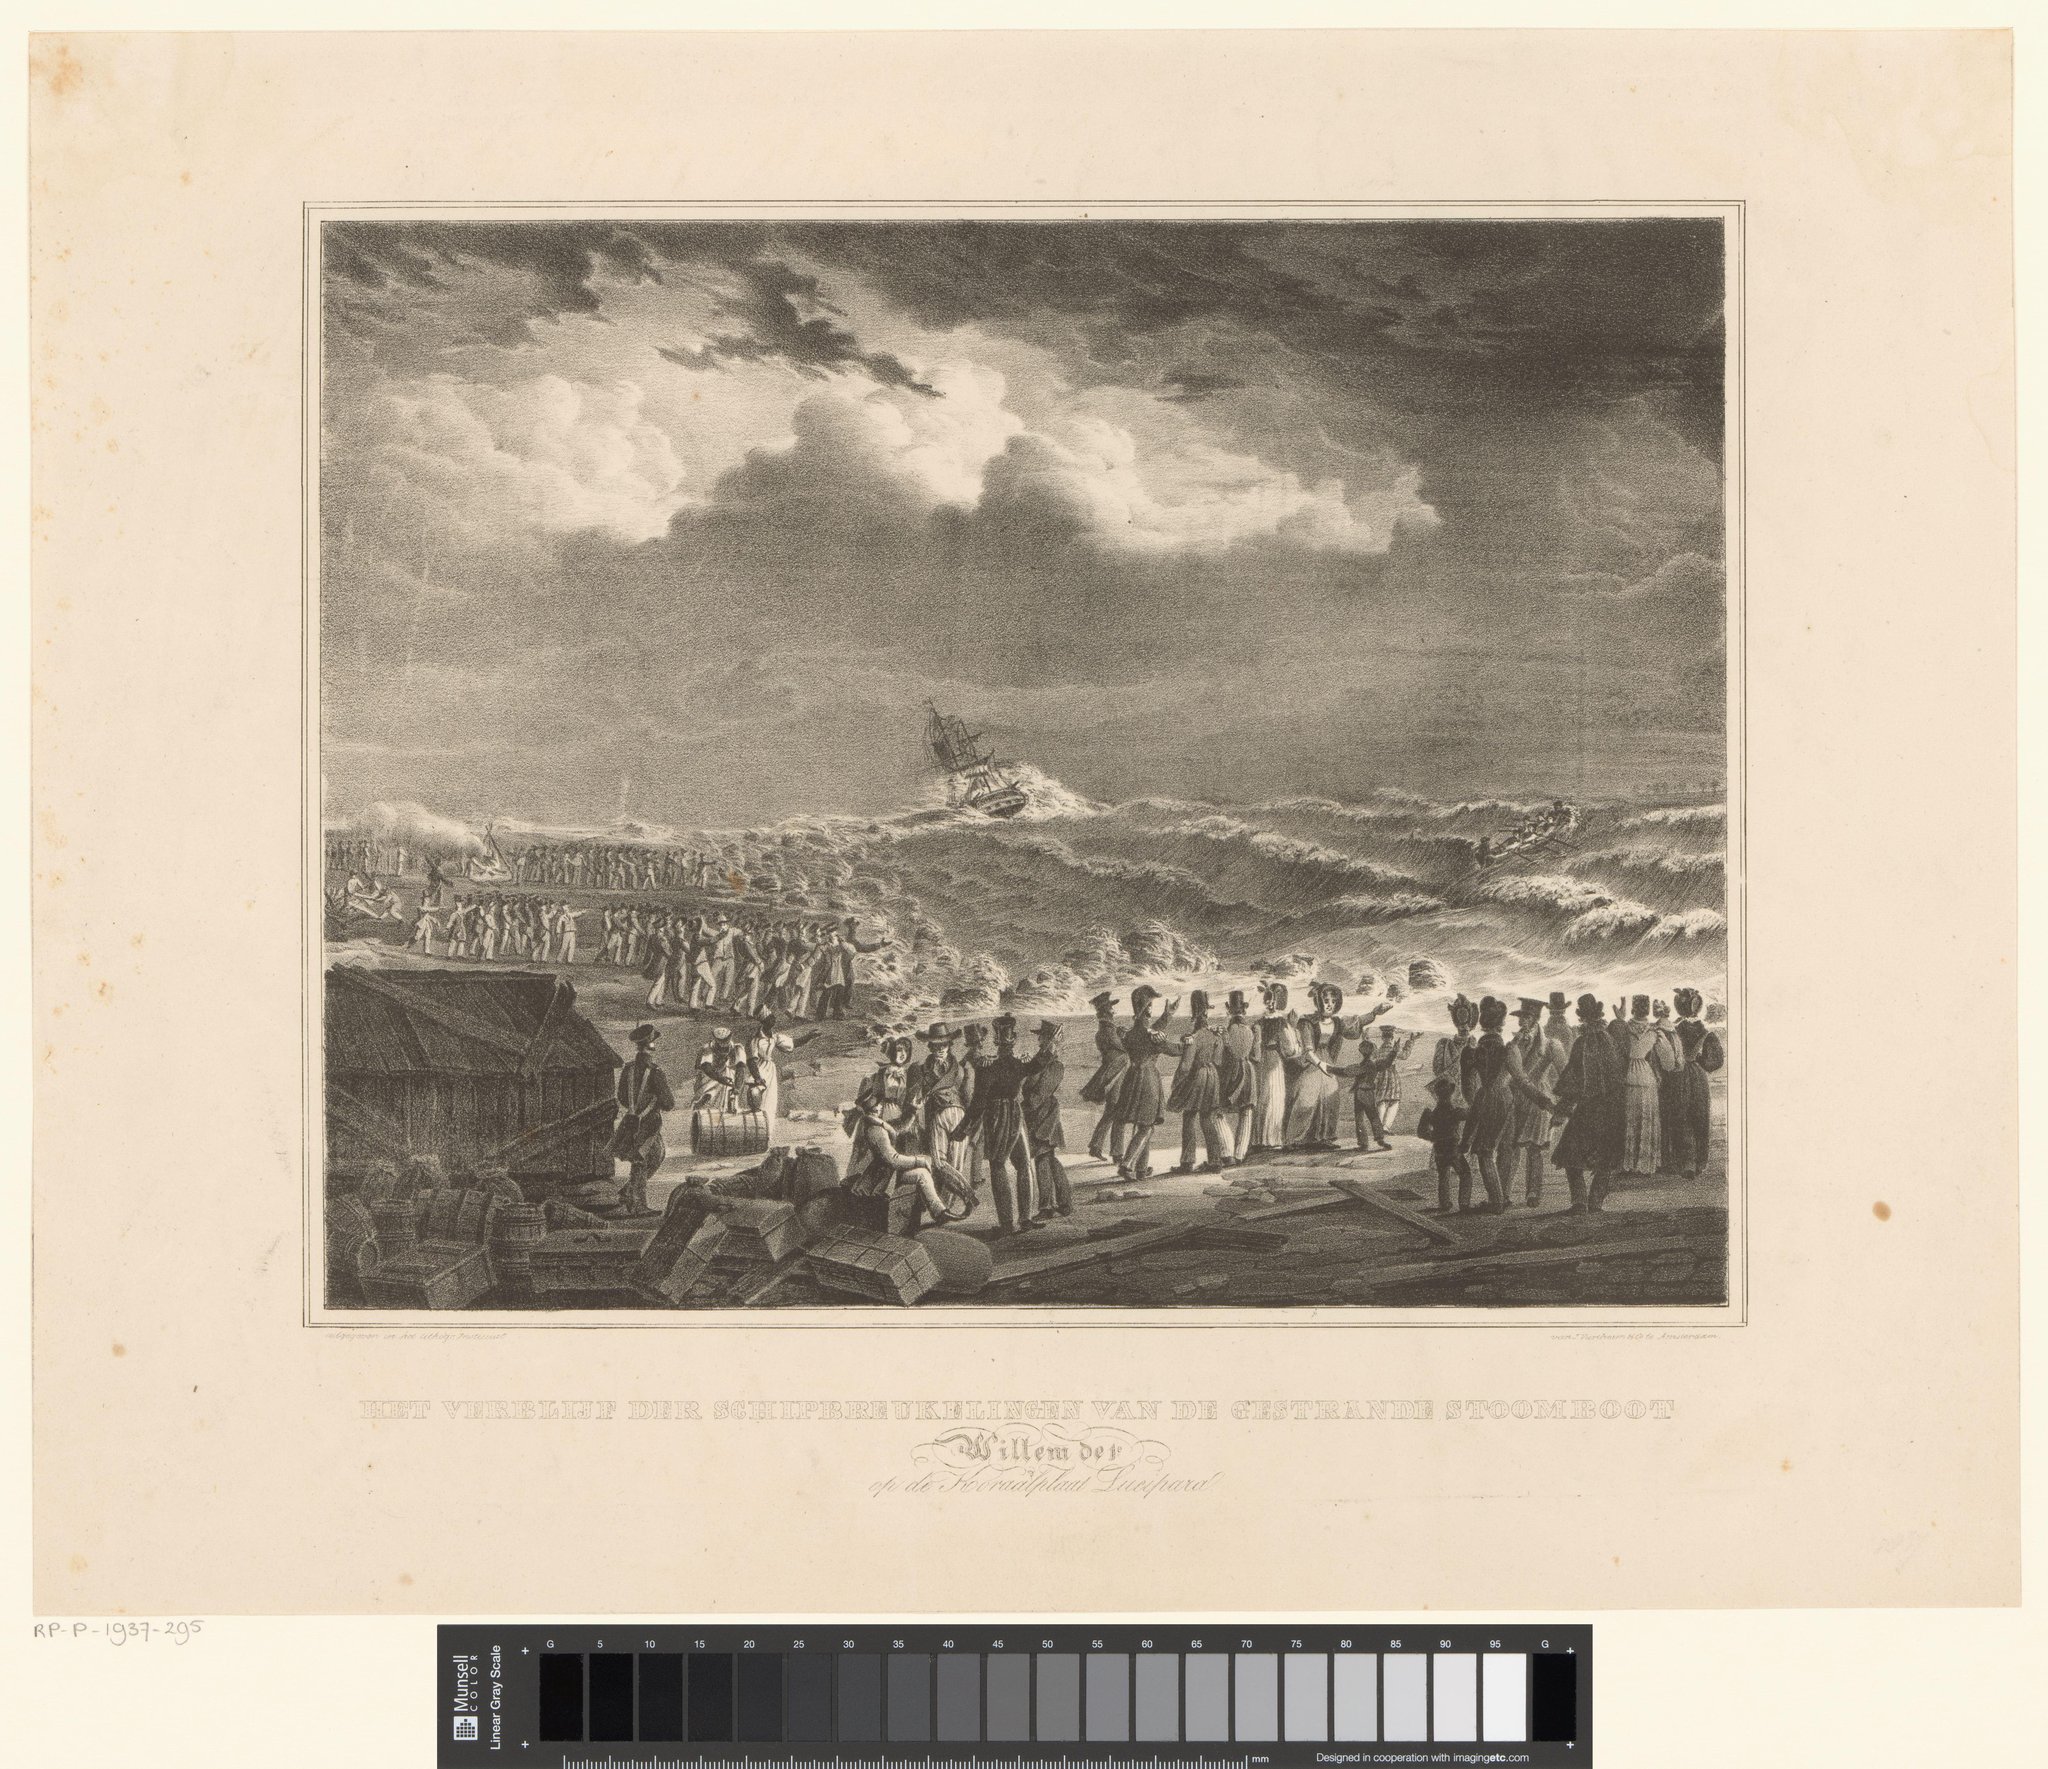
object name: print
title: Schipbreuk van het stoomschip Willem I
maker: Anonymous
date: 1837-1839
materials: paper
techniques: lithograph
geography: amsterdam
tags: shipwreck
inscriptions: collector's mark: Lugt 2228, collector's mark: Lugt 2760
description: De schipbreukelingen van de Willem I aan land op één van de Lucipara eilanden na het stranden van het raderstoomschip Willem I op een koraalrif in de Bandazee in de nacht van 5 op 6 mei 1837. Op de achtergrond vergaat het schip in de golven, rechts een sloep in het water.